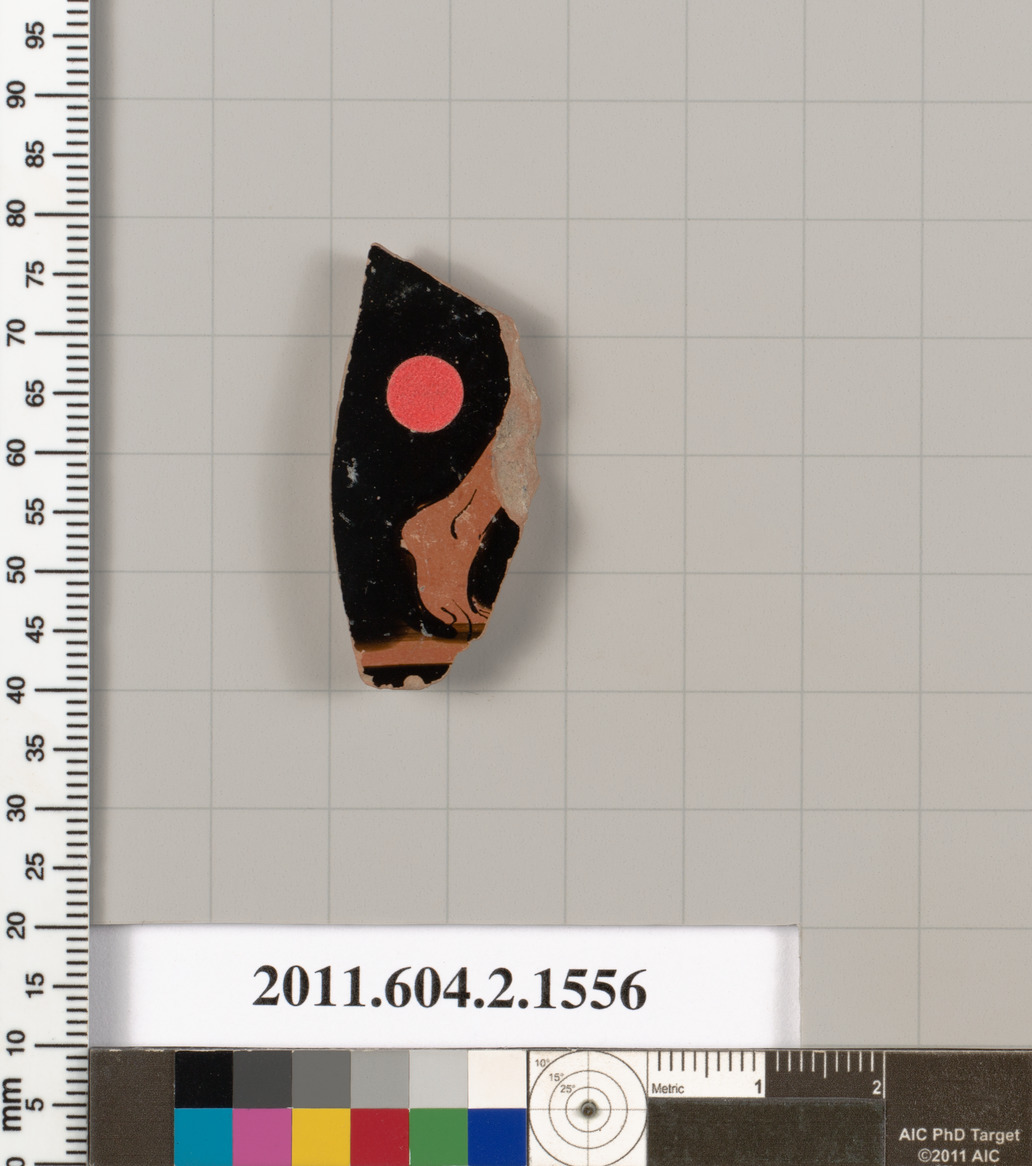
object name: skyphos fragment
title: Terracotta fragment of a skyphos (deep drinking cup)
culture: greek, attic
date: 475-451 BCE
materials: terracotta